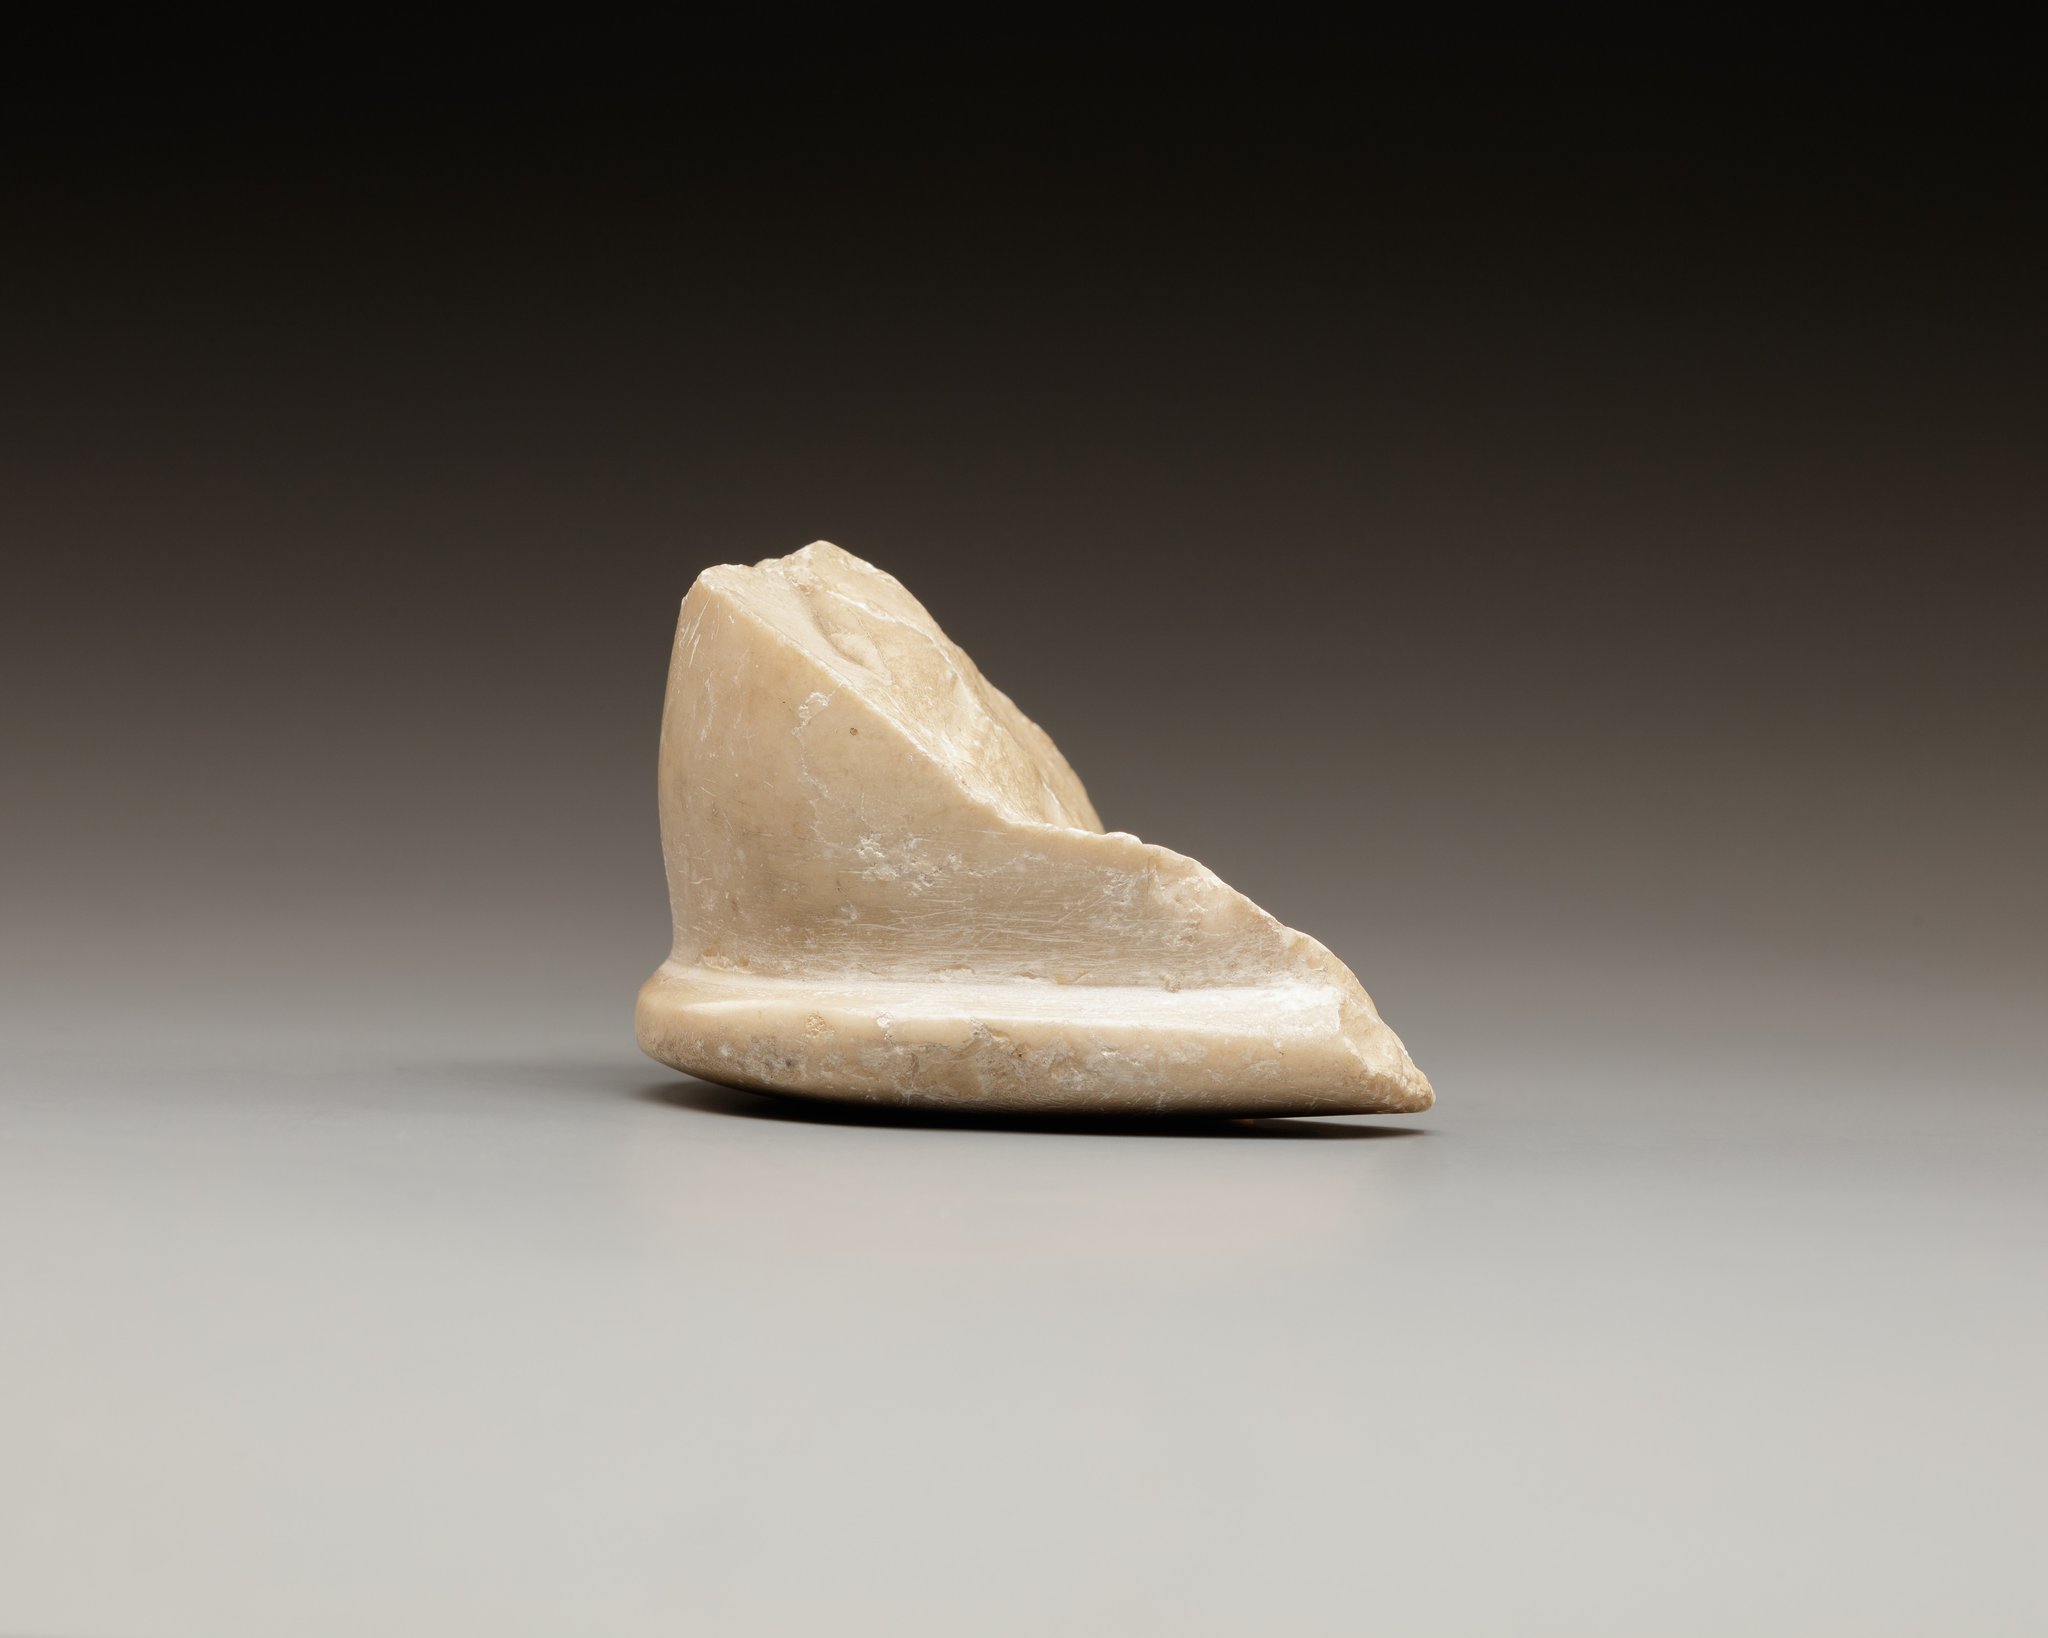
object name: akhenaten or nefertiti prostrate, heel in sandal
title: Heel in sandal, of Akhenaten or Nefertiti prostrate?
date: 1352-1336 BCE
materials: limestone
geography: egypt